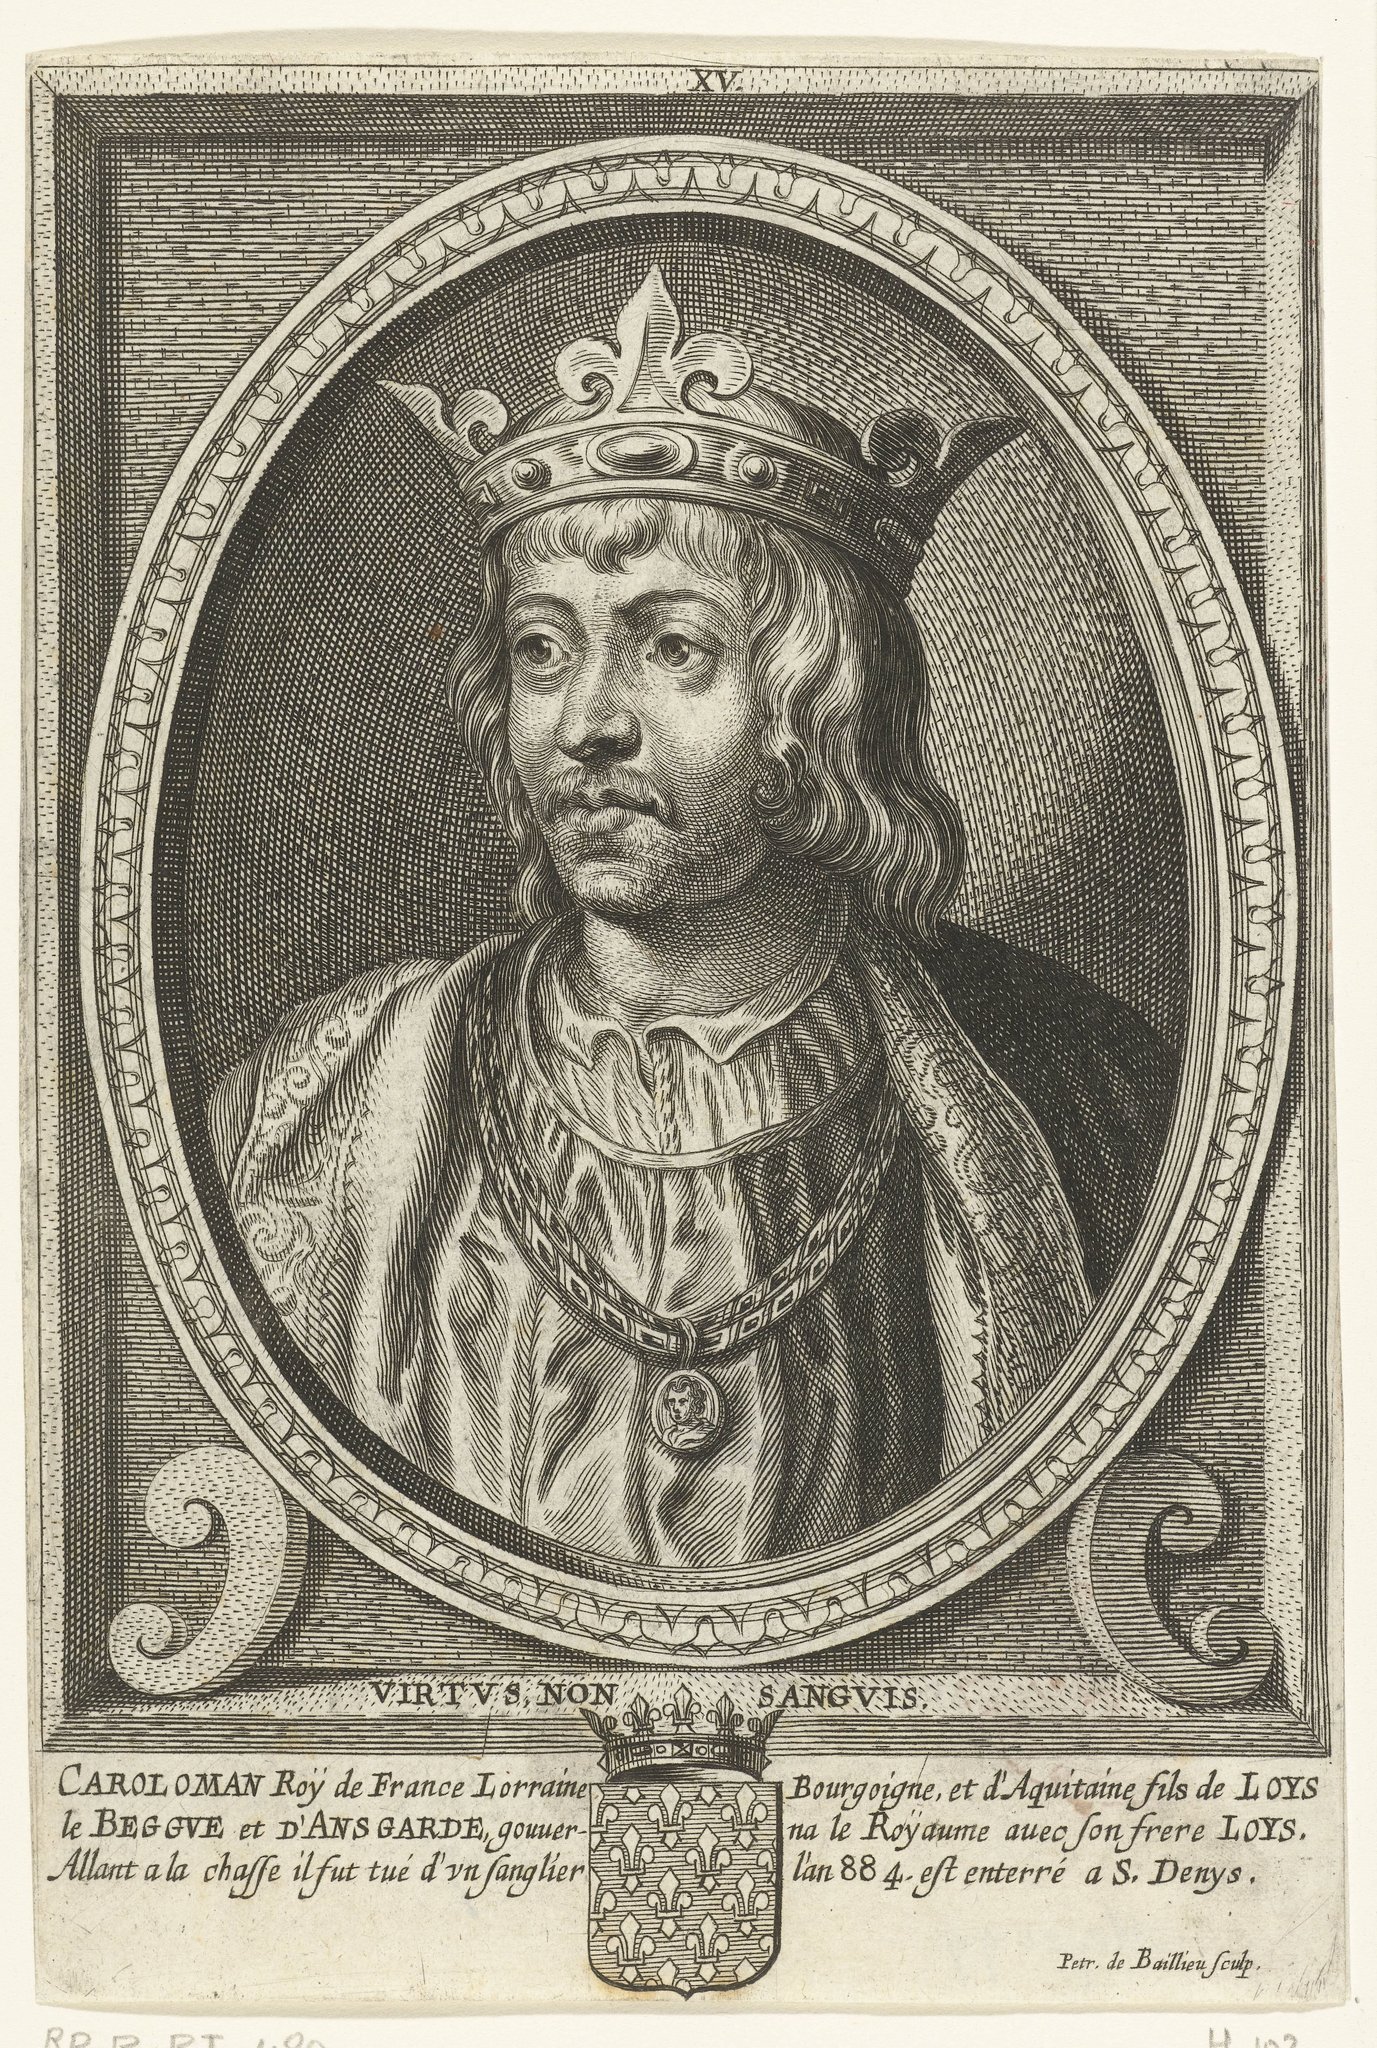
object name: print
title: Caroloman Roy de (...) enterré a S. Denys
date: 1623-1660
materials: paper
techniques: engraving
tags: koning, karloman ii (koning van west-francië)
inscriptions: collector's mark: Lugt 240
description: Prent gebruikt voor: Les Effigies des Souverains princes et Ducs de Brabant. Joannes Meyssens (uitgever), Antwerpen 1661. De publicatie bevat vierenvijftig portretten waarvan zes door Pieter de Bailliu.